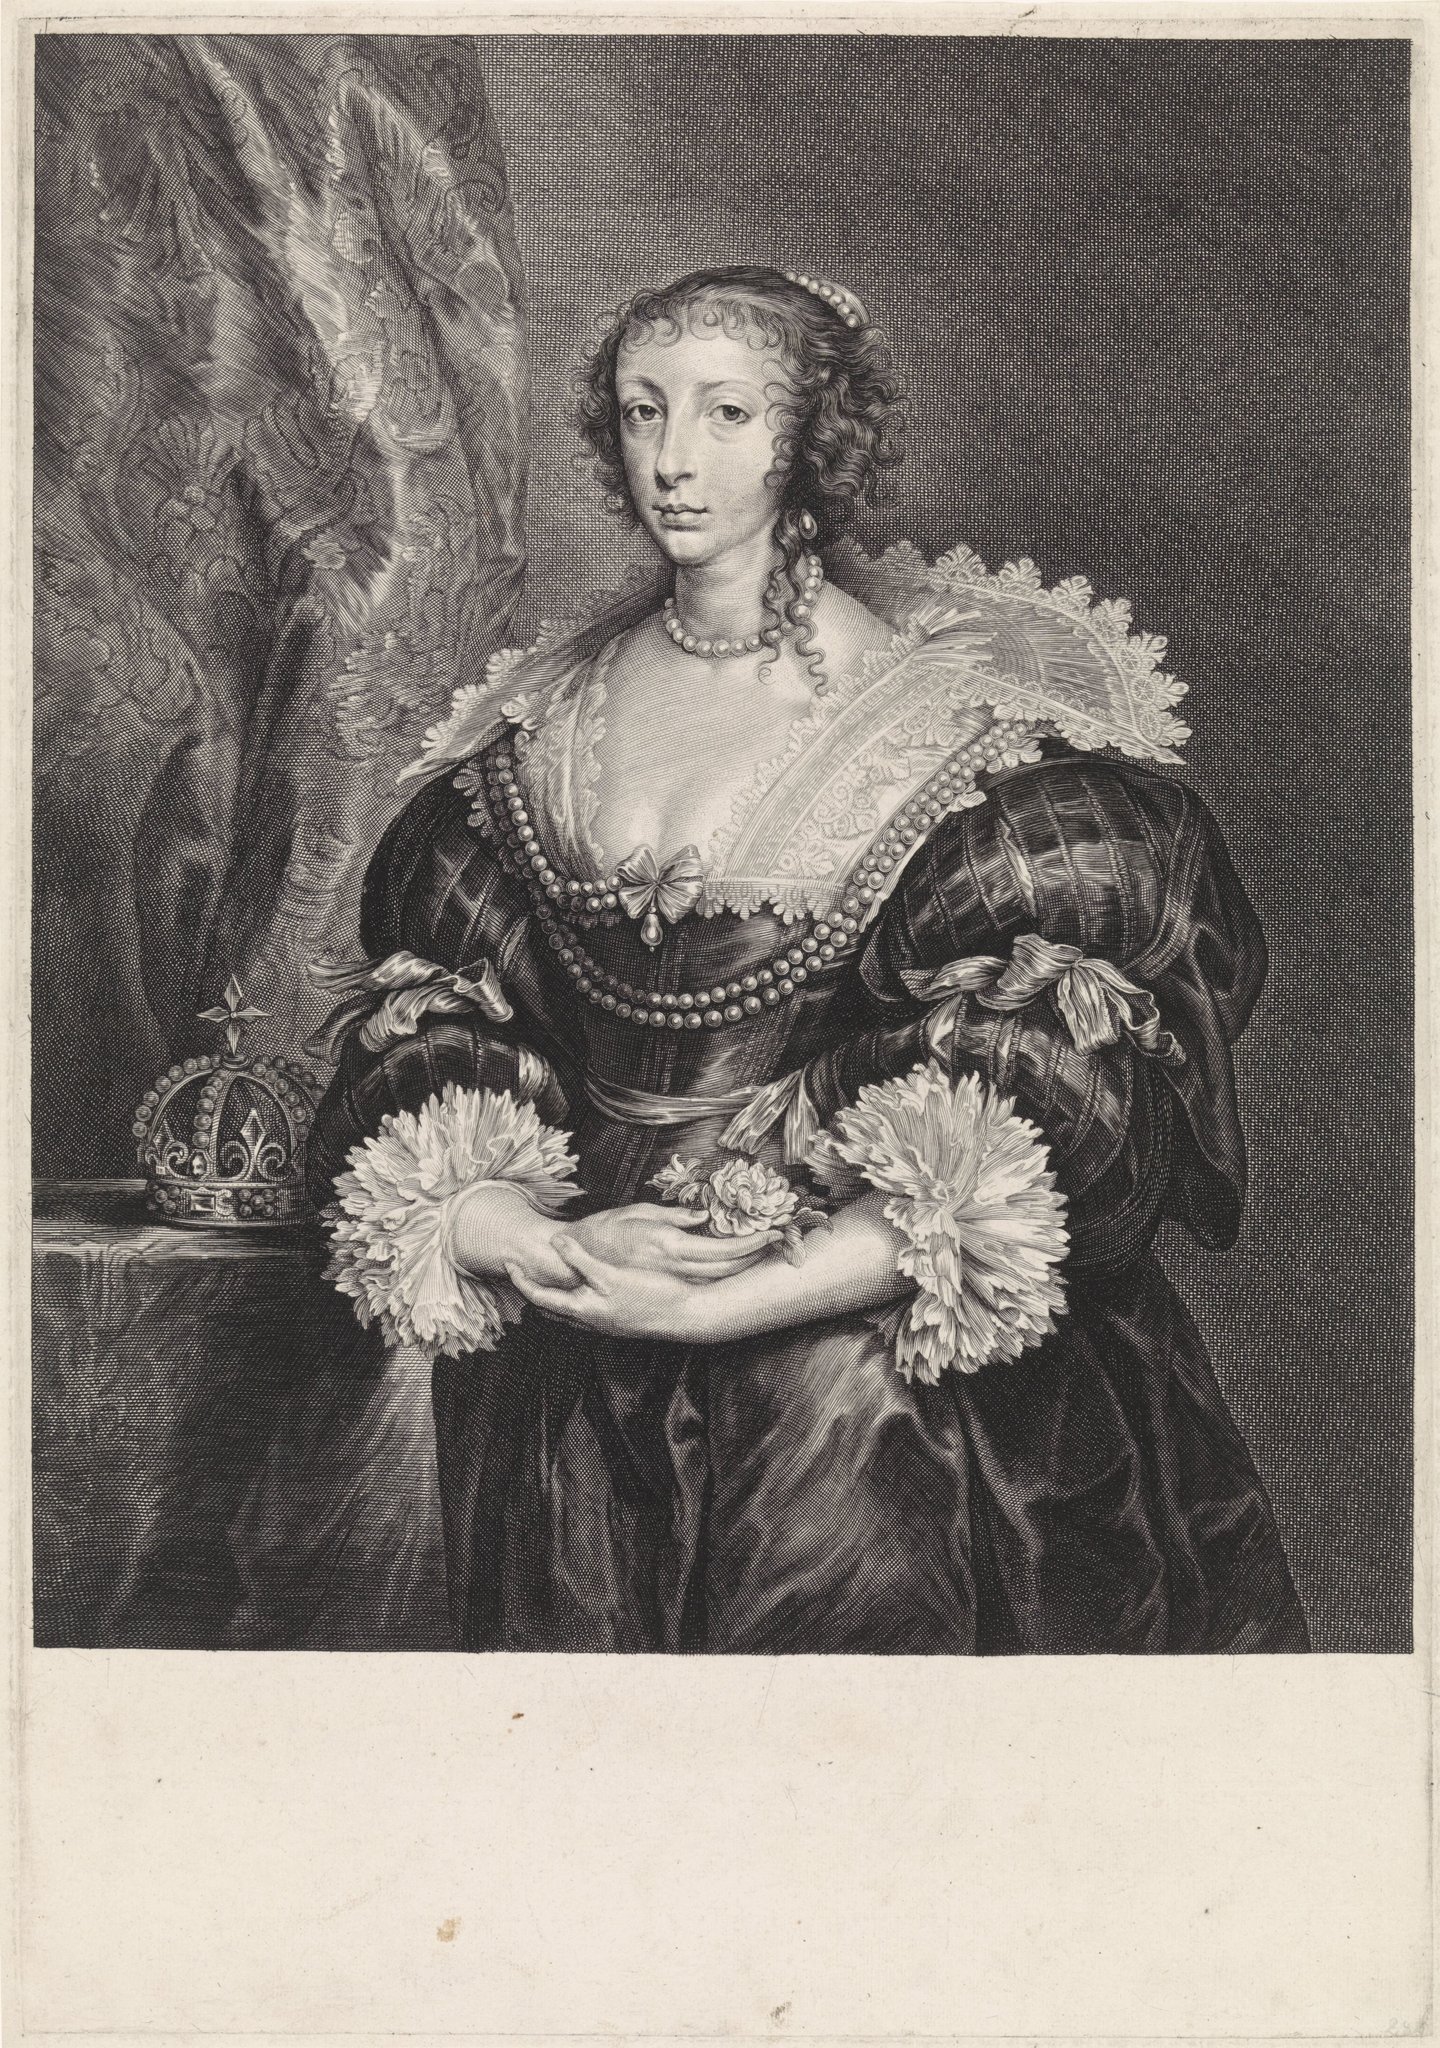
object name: print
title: Portret van Henriette Maria, koningin van Engeland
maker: pieter de jode (ii)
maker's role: draughtsman, print maker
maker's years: 1606-1674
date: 1628-1670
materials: paper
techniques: engraving, etching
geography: england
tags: henriëtta maria van frankrijk (koningin van engeland, schotland en ierland), crown (symbol of sovereignty)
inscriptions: collector's mark: Lugt 240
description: Portret van Henriette Maria, ten halven lijve. Ze staat naast een tafel en heeft een bloem in haar rechterhand. Op de tafel ligt haar kroon. Met een lege marge onder de geportretteerde.